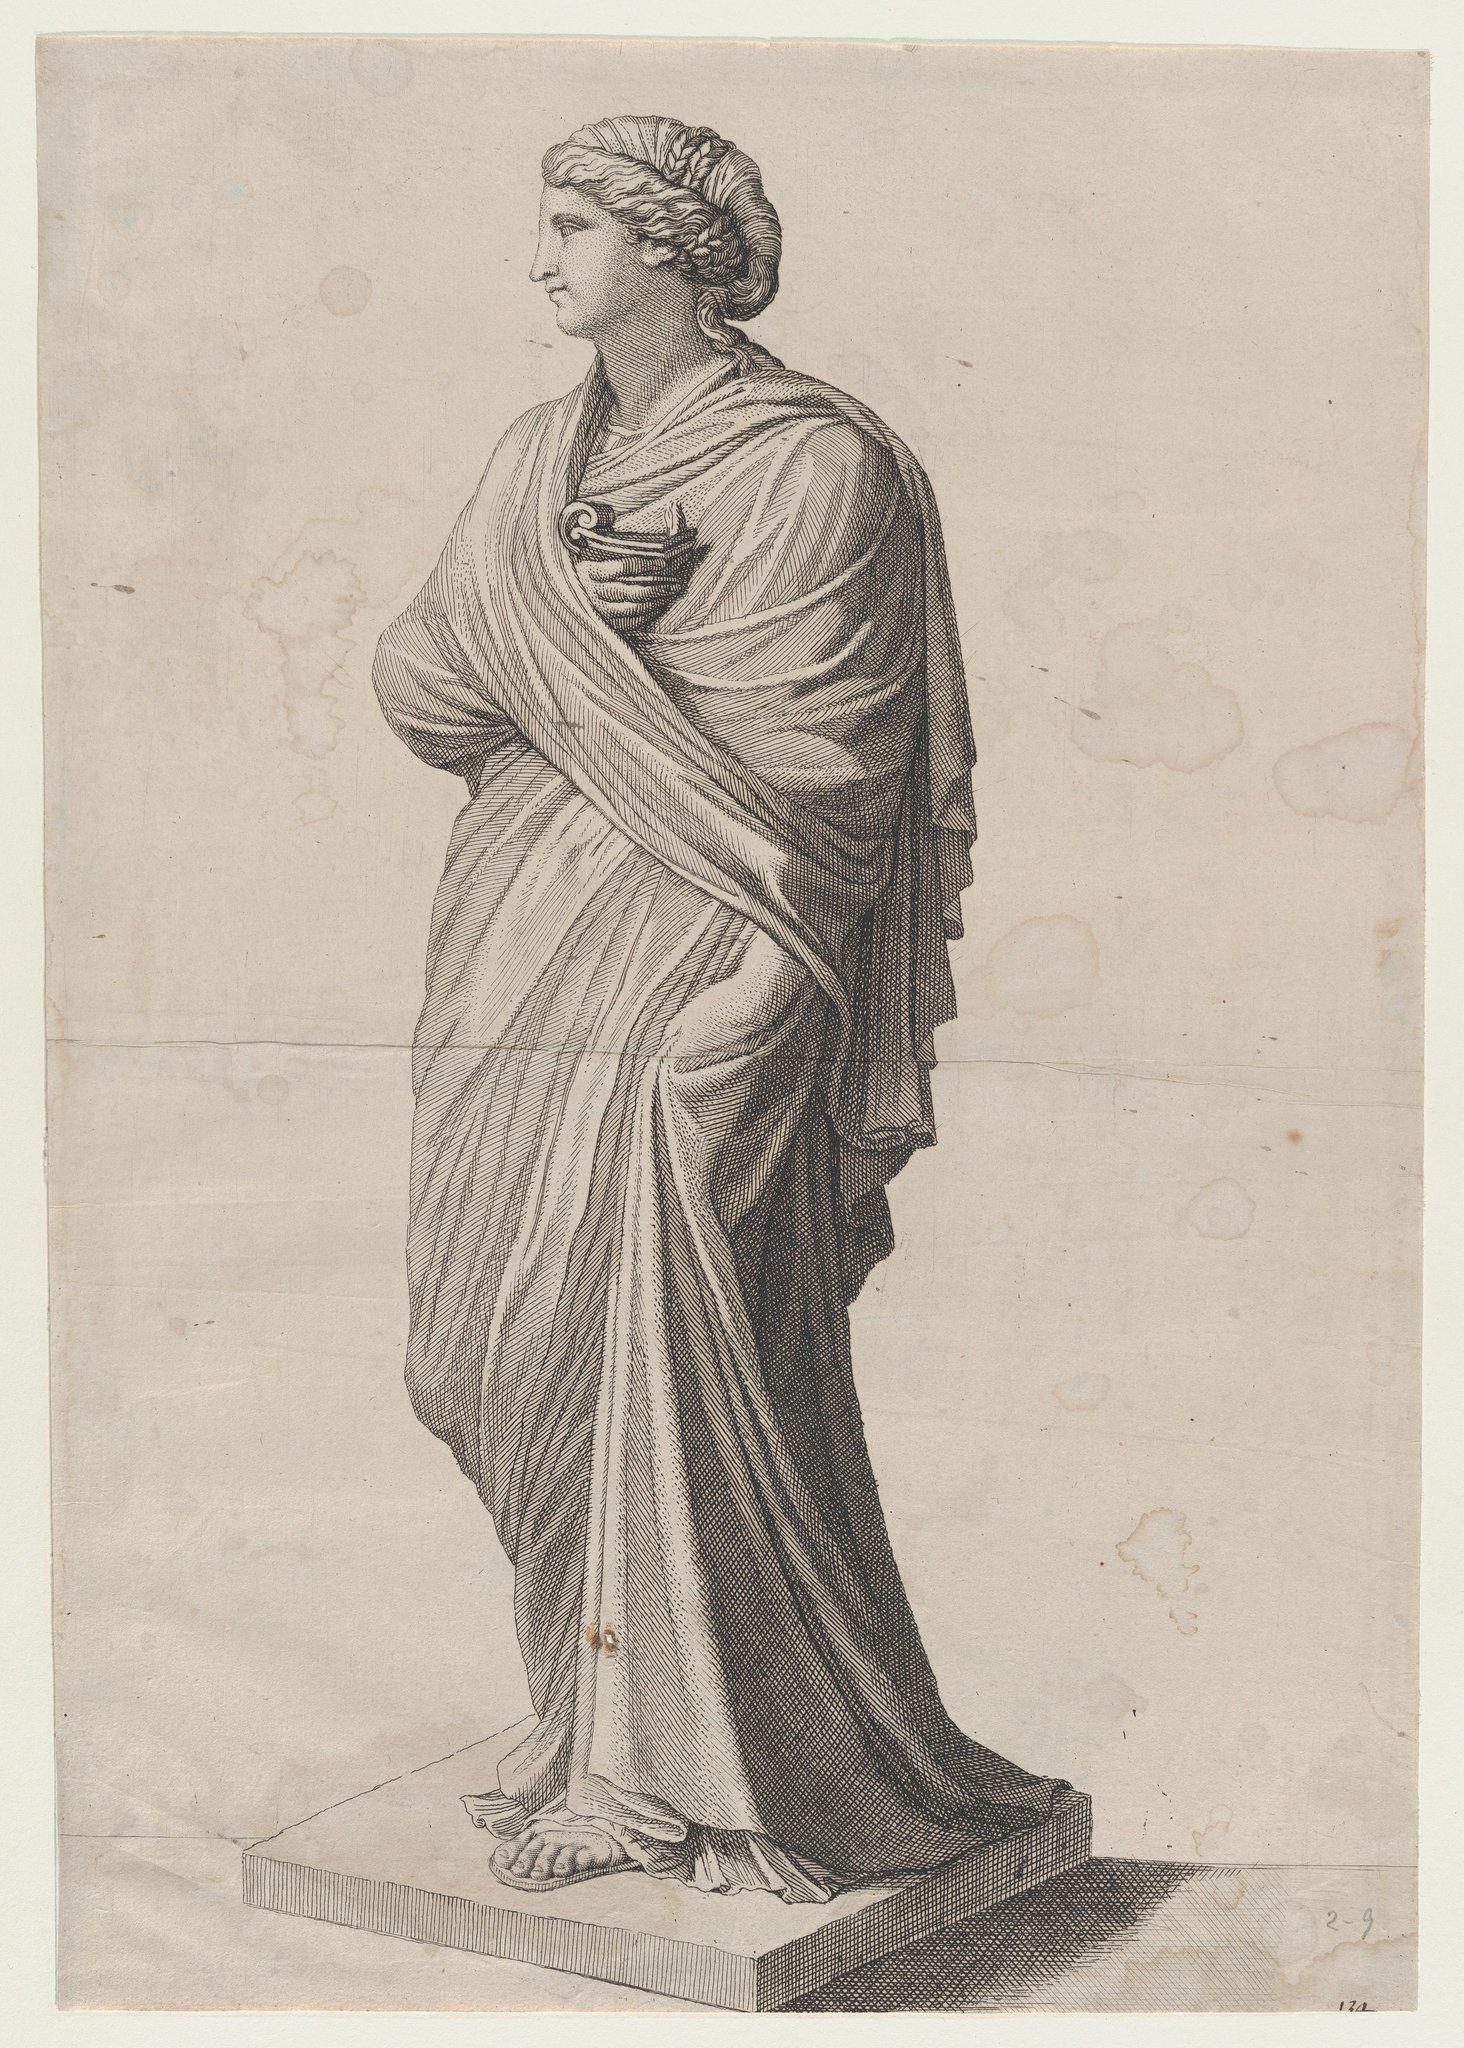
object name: print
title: A Vestal Virgin (?), from "Speculum Romanae Magnificentiae"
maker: Anonymous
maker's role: artist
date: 1501-1600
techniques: etching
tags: women